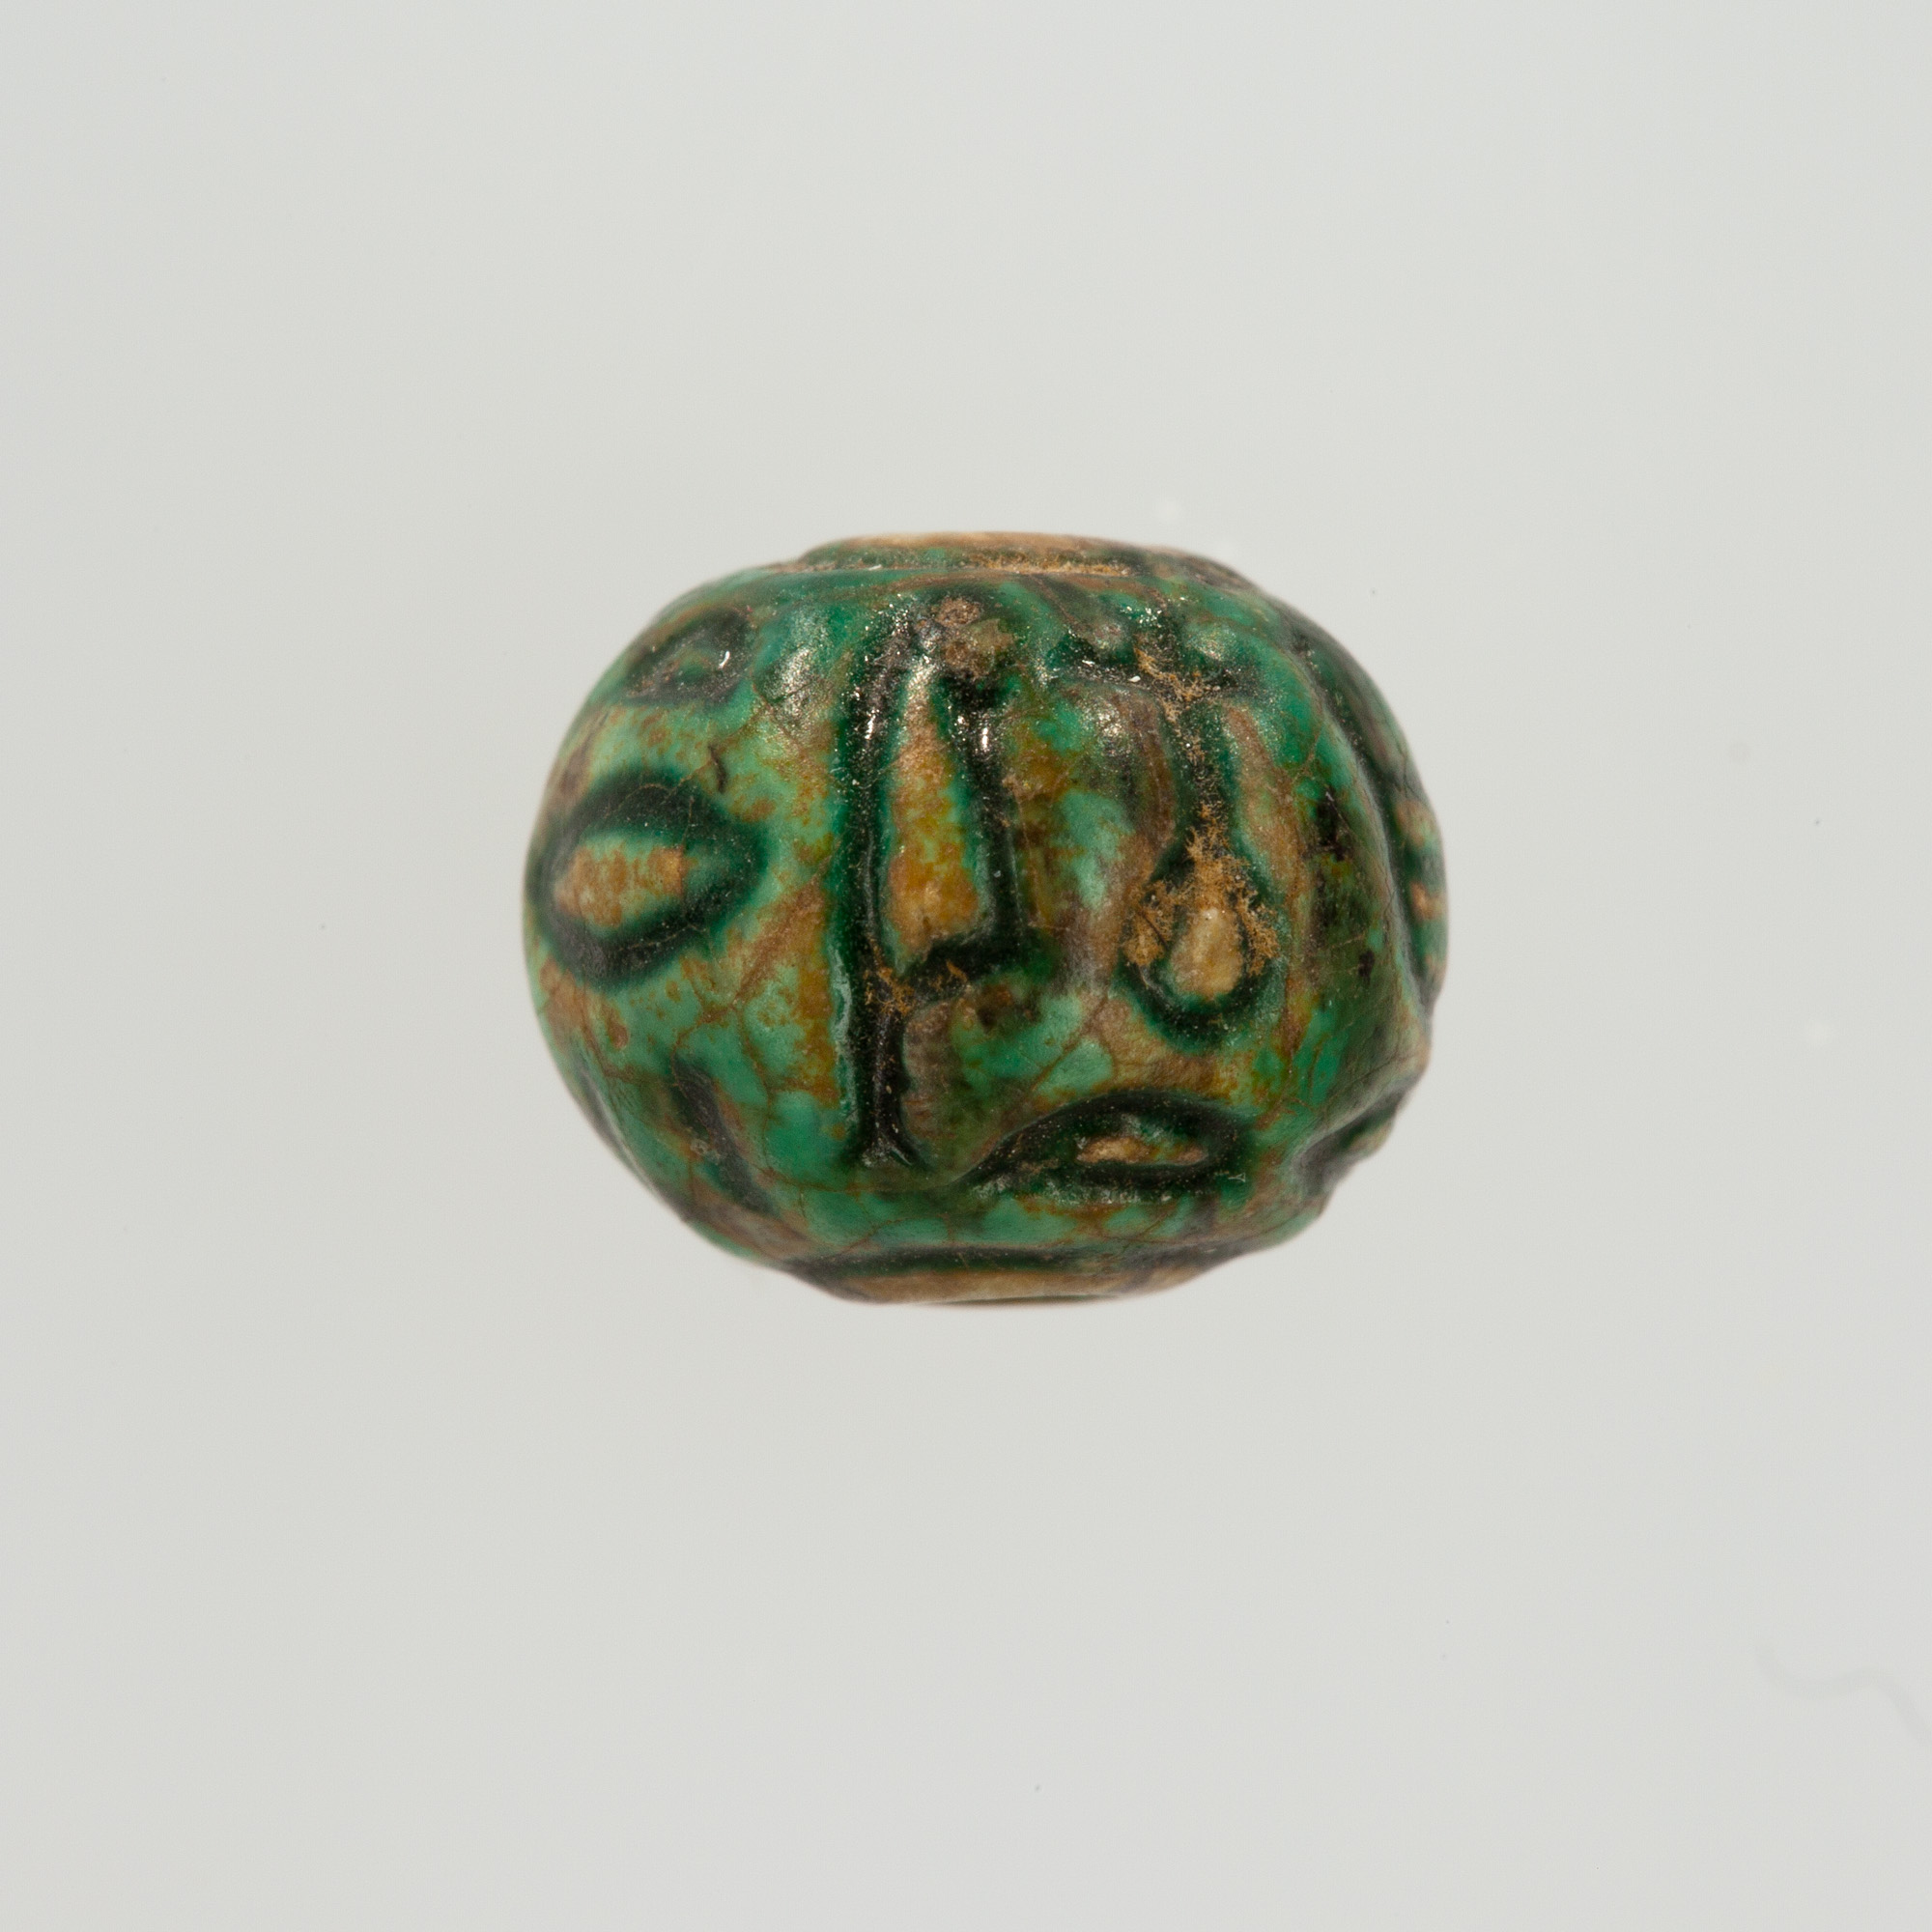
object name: bead, ahmose nefertari, god's wife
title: Bead Inscribed for the God's Wife Nefertari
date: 1550-1479 BCE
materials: stone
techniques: glazing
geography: egypt